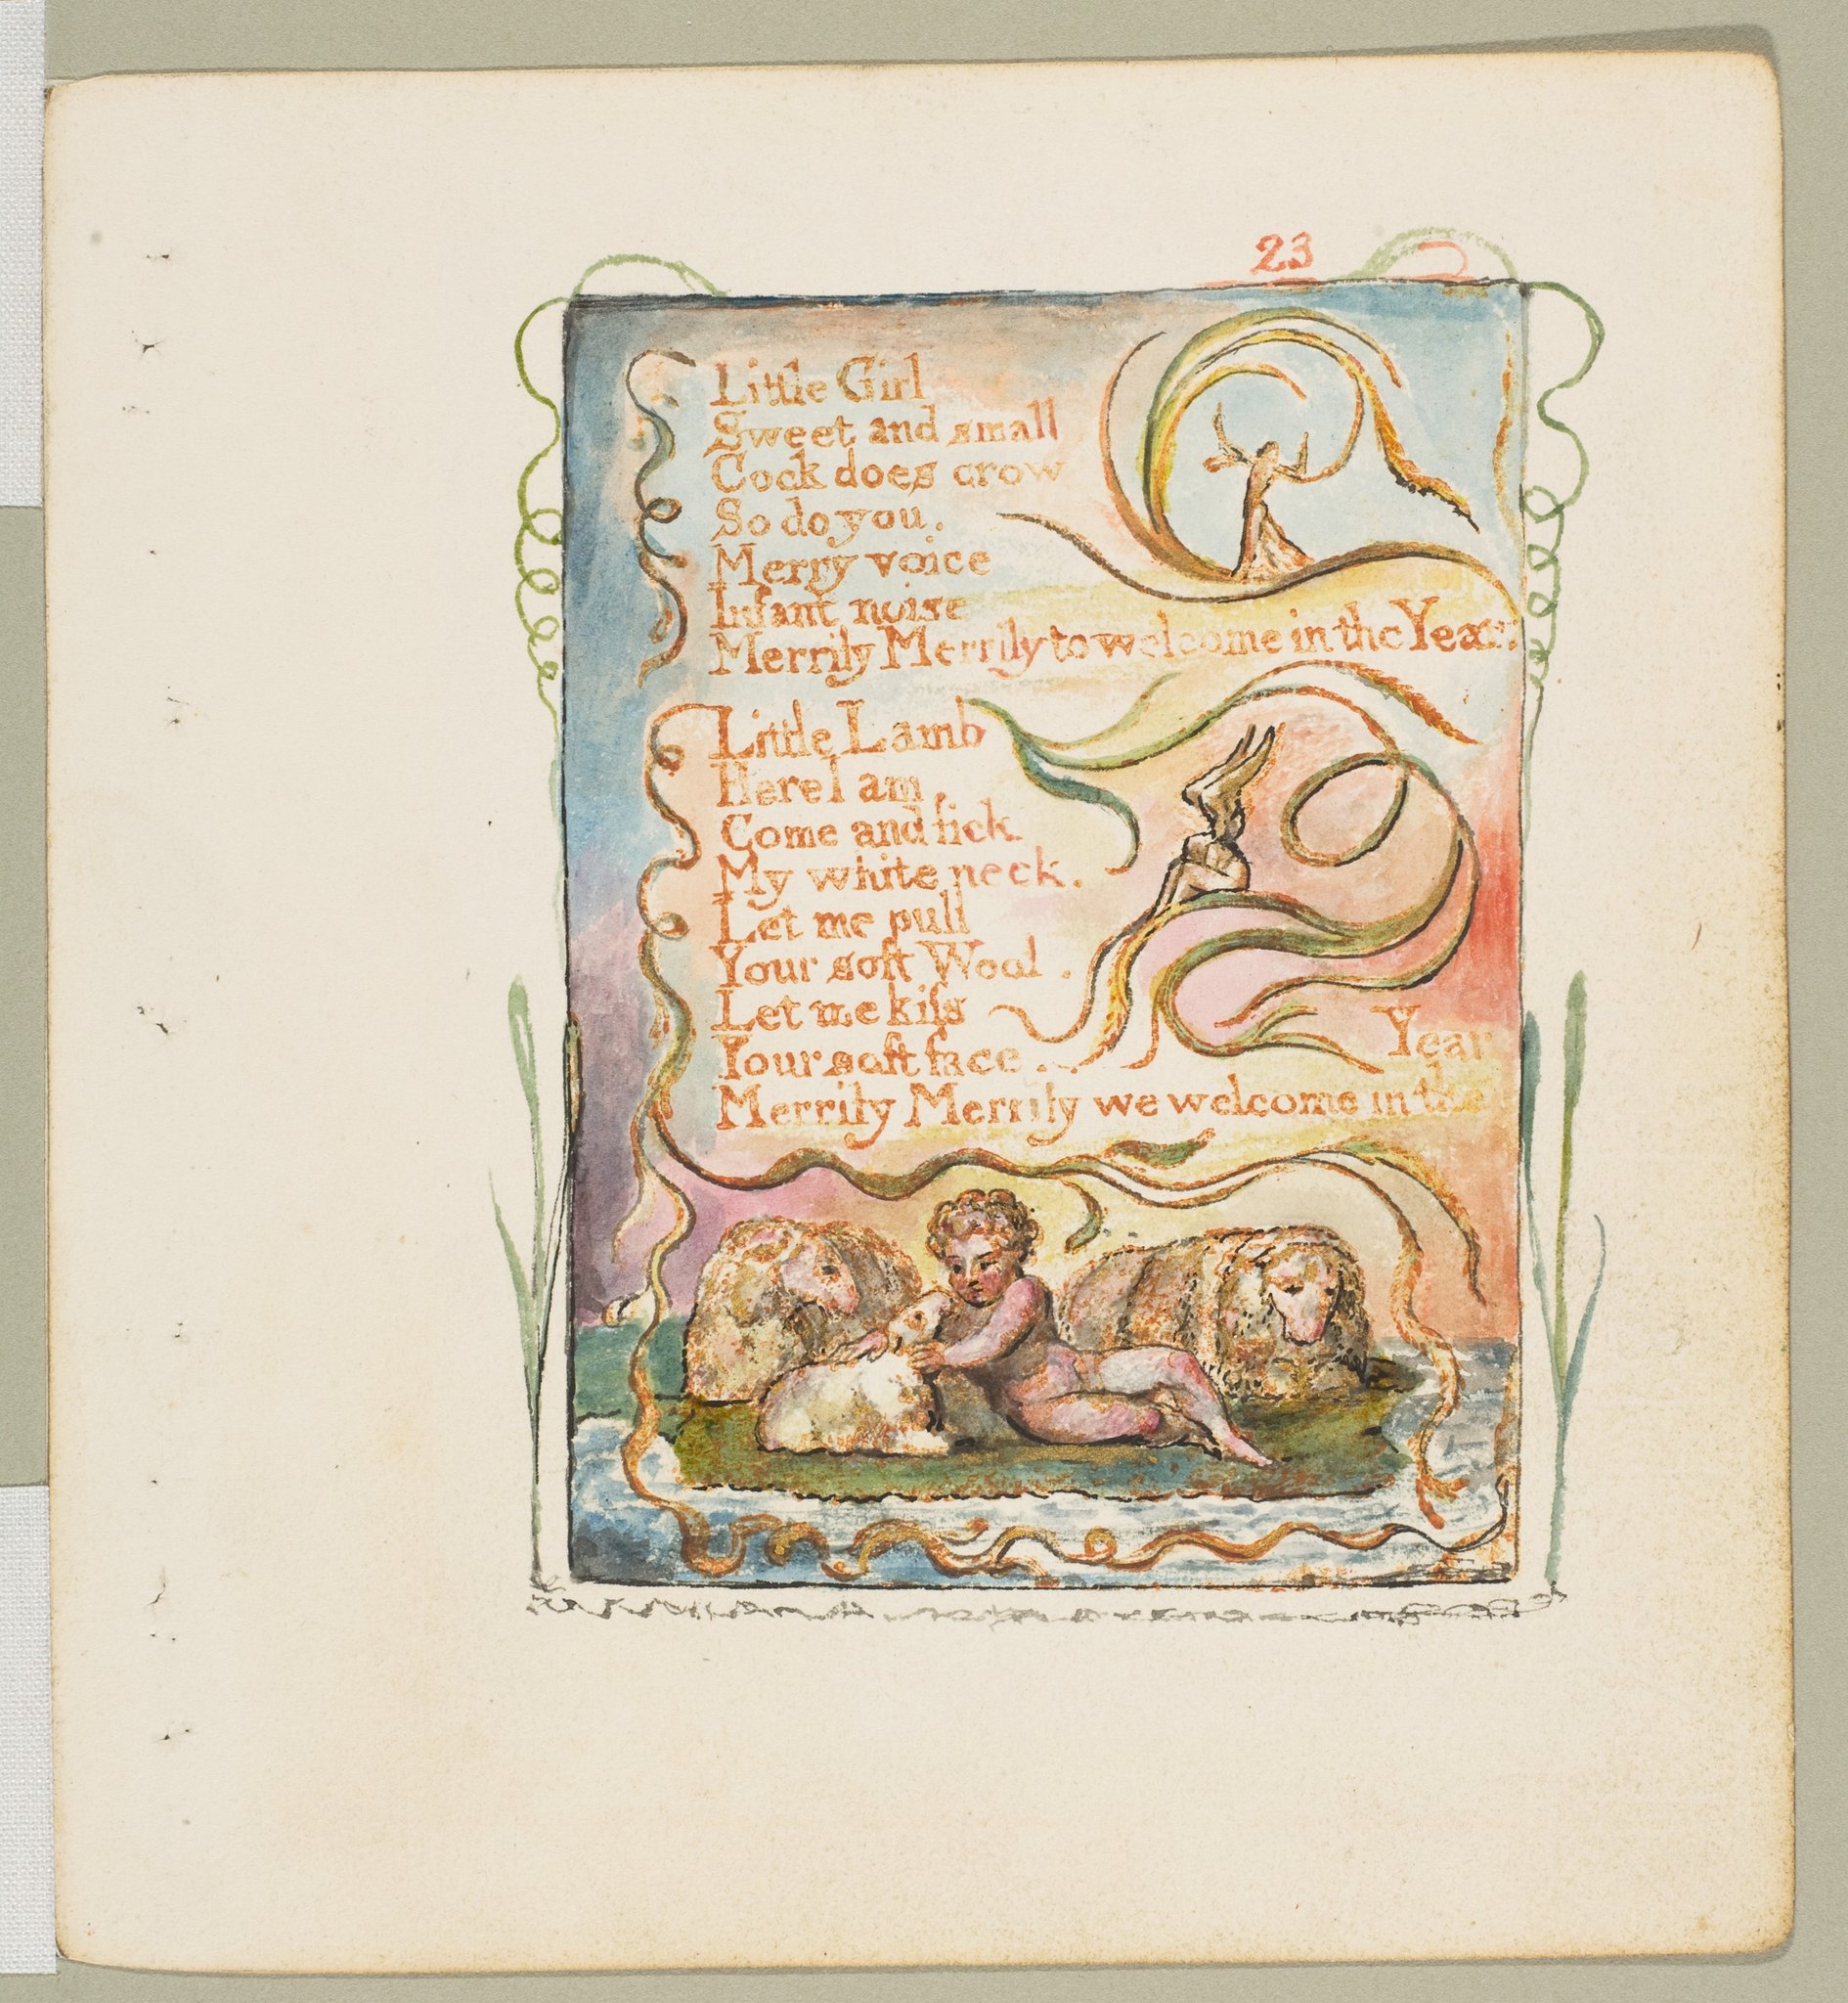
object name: print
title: Songs of Innocence: Spring (second plate)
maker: william blake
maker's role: artist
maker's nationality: british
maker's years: 1757-1827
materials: gold, ink, shell, watercolor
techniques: etching, hand coloring, printing, relief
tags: animals,girls